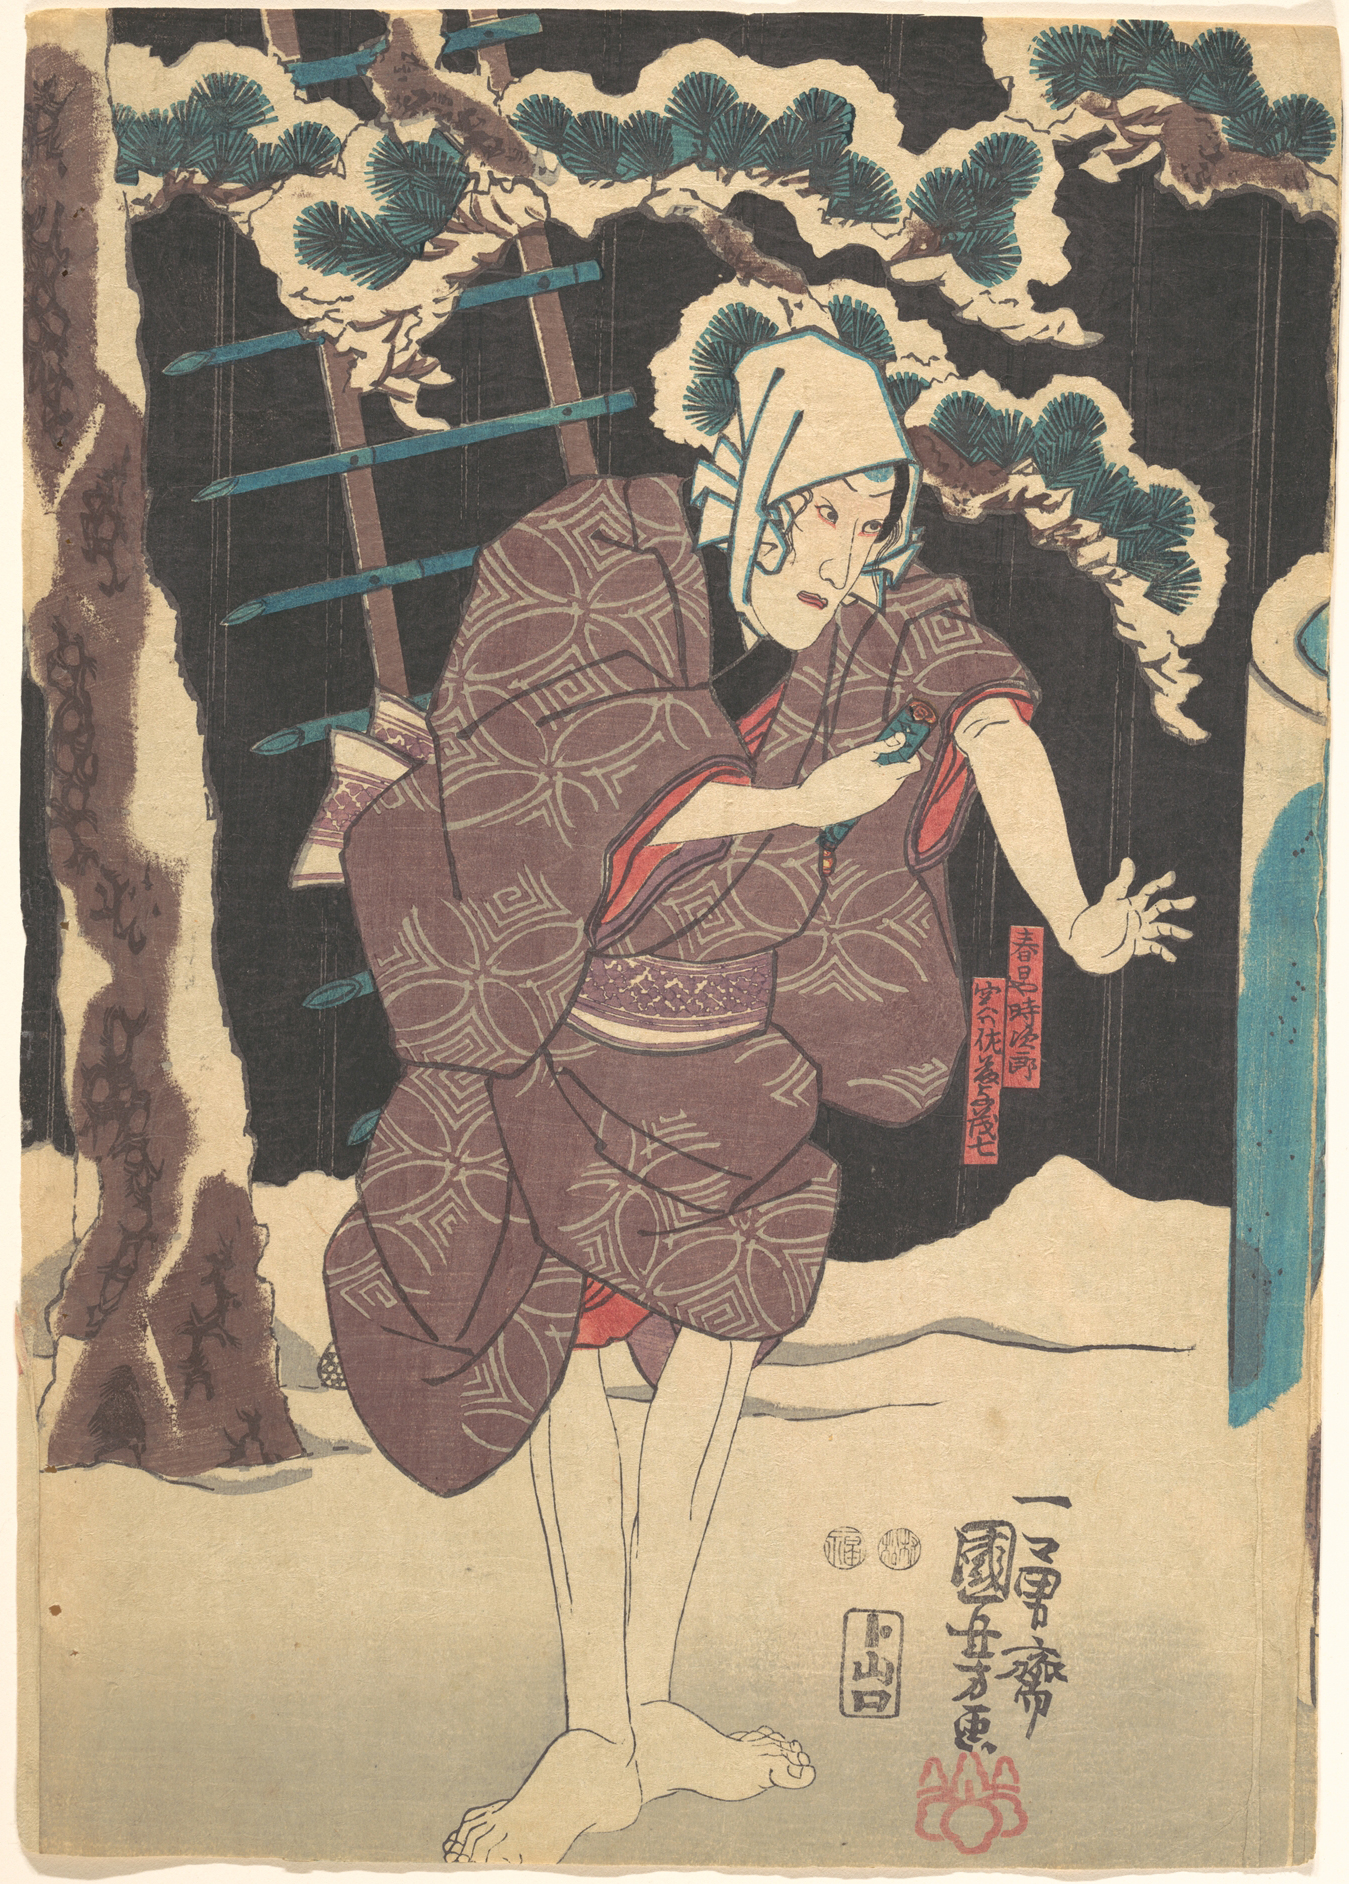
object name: print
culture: japanese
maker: utagawa kunisada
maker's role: artist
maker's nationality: japanese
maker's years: 1786-1864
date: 1801-1900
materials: ink, paper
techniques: woodblock print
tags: men